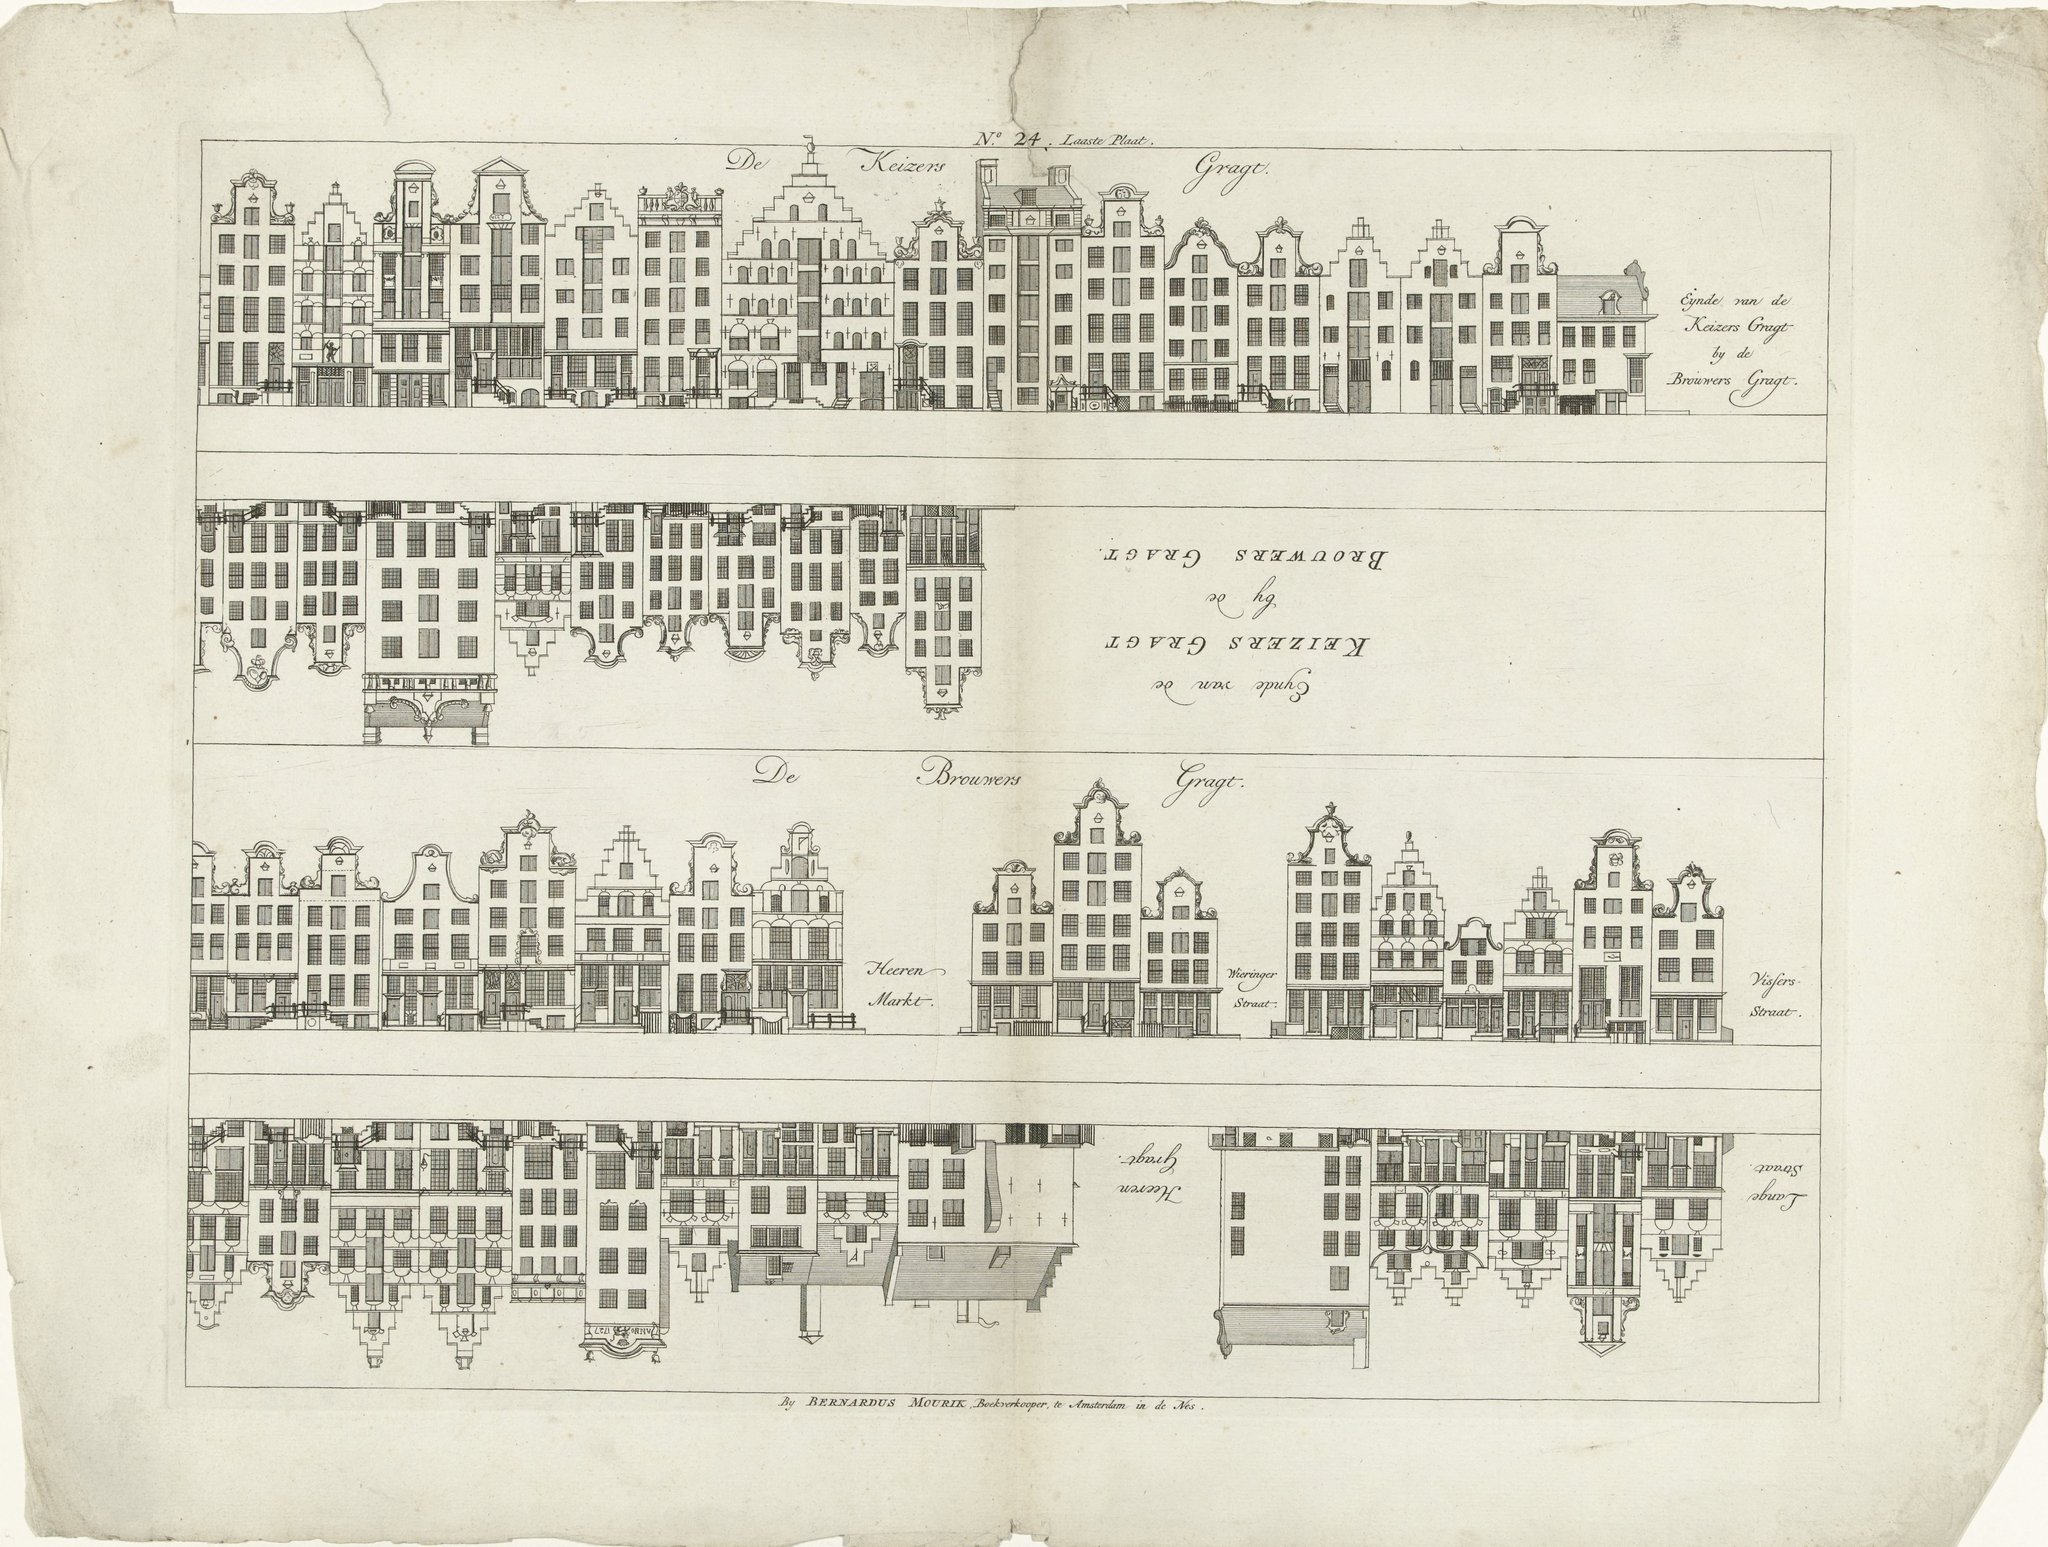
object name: print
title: Gevels van huizenrijen aan de Keizersgracht tot het einde bij de Brouwersgracht en de Brouwersgracht van de Herenmarkt naar de Langestraat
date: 1768-1771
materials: paper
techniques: etching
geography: amsterdam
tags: front façade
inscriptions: collector's mark: Lugt 2233, collector's mark: Lugt 2228